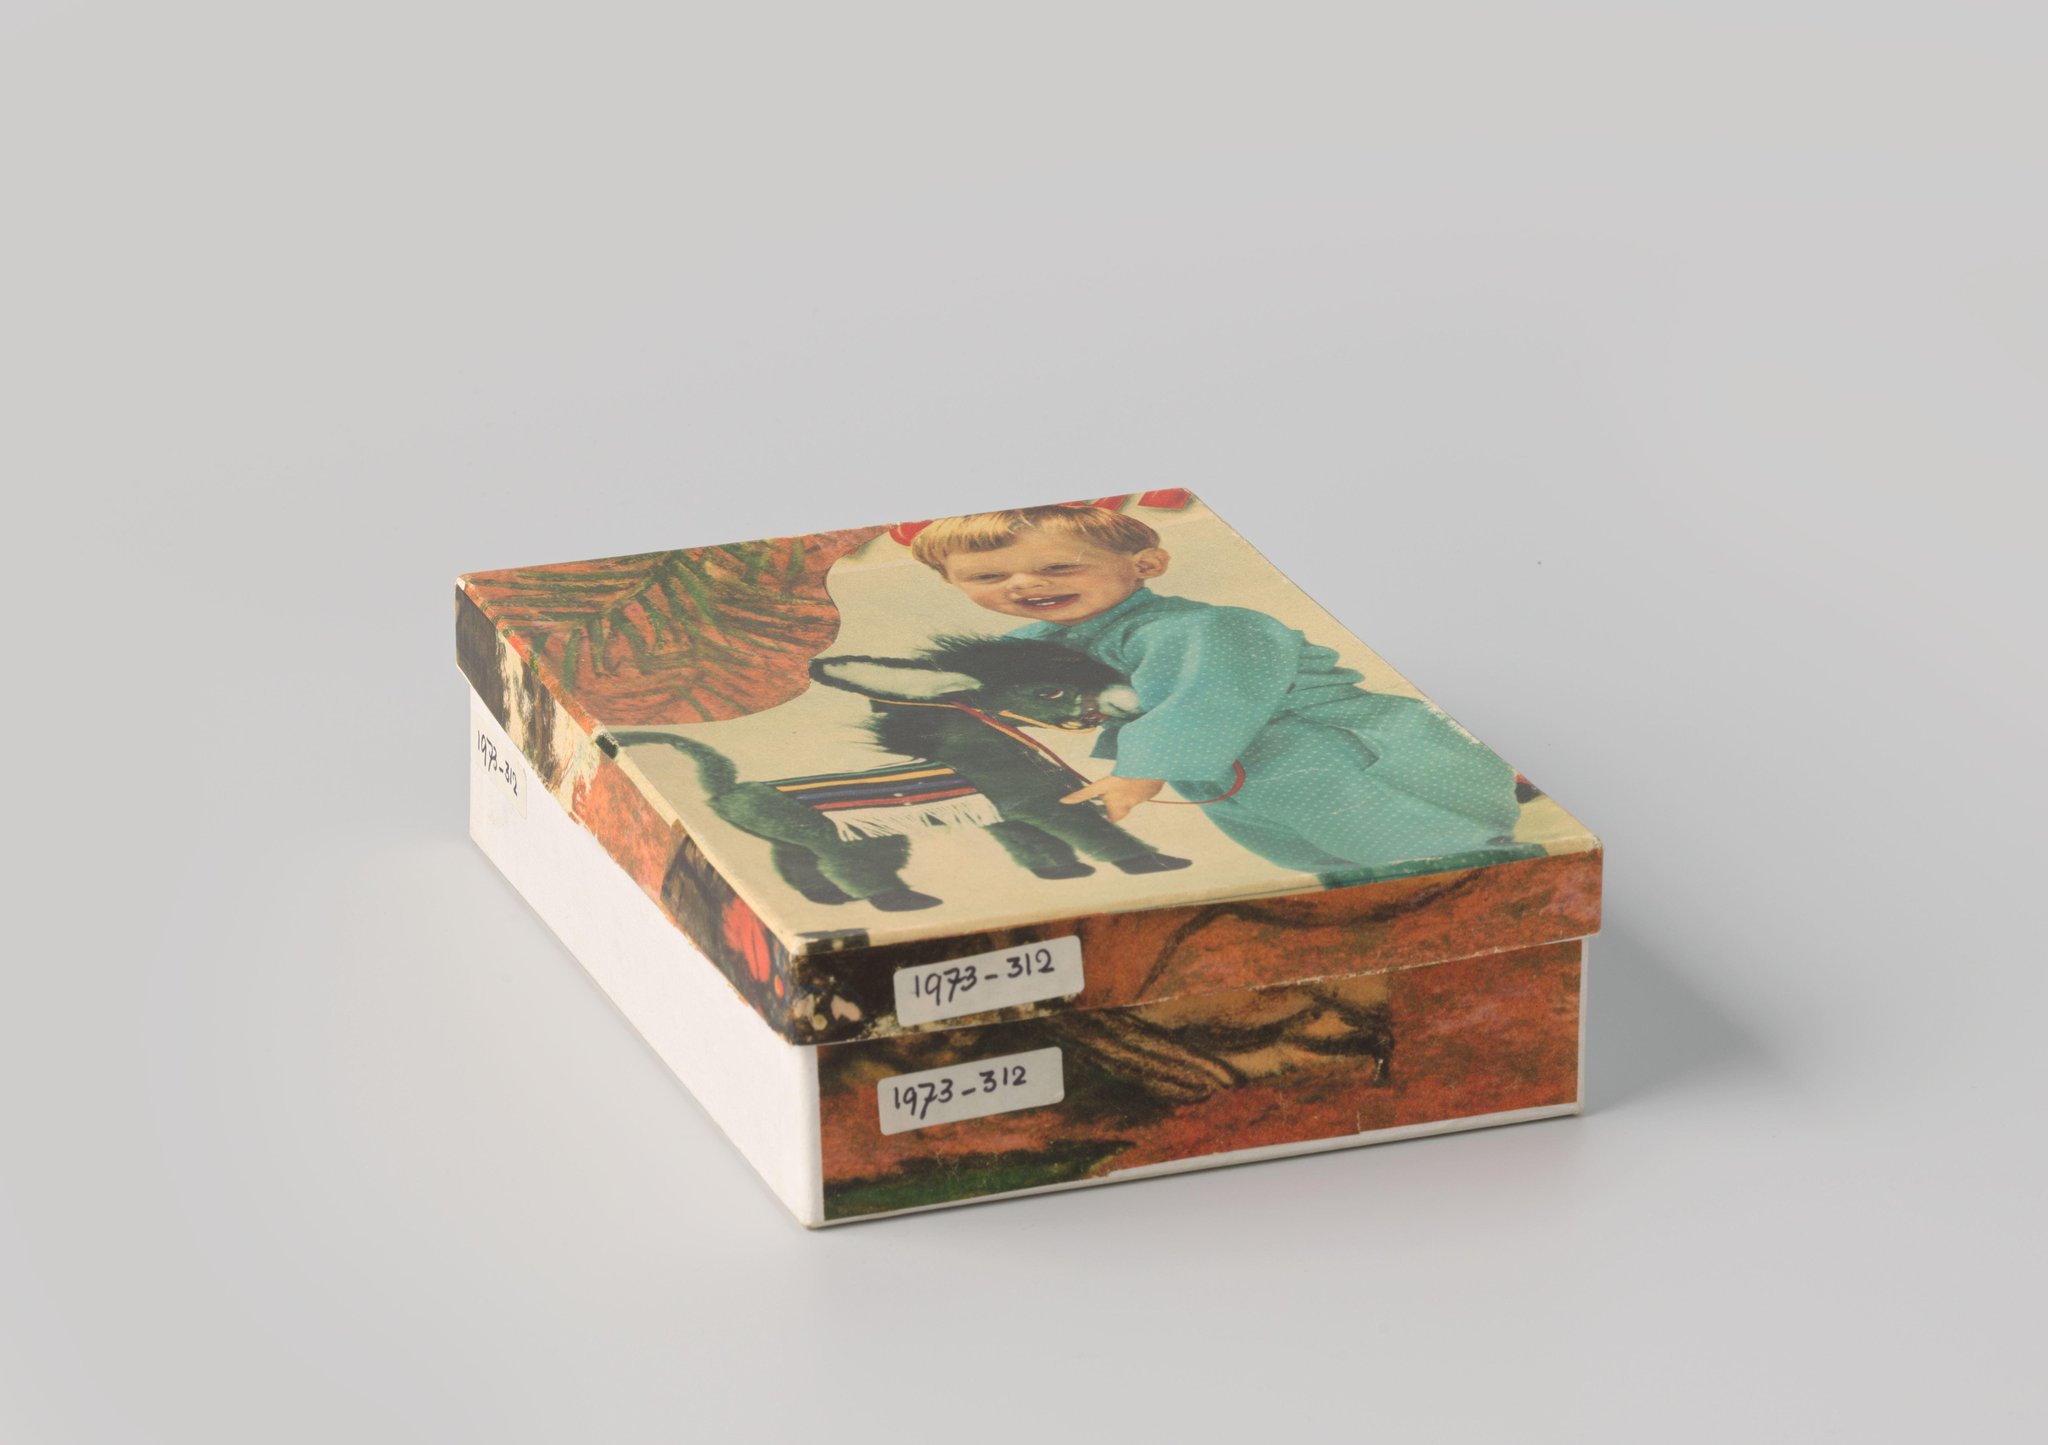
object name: box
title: Doos met losse deksel, van karton beplakt met papier waarop een kleuter met een speelgoed paard; bevatte poppenkledingstukken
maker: Anonymous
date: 1910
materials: cardboard, paper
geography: netherlands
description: Doos met losse deksel, van karton beplakt met papier waarop een kleuter met een speelgoed paard. Bevatte poppenkledingstukken horende bij pop "LILLY".